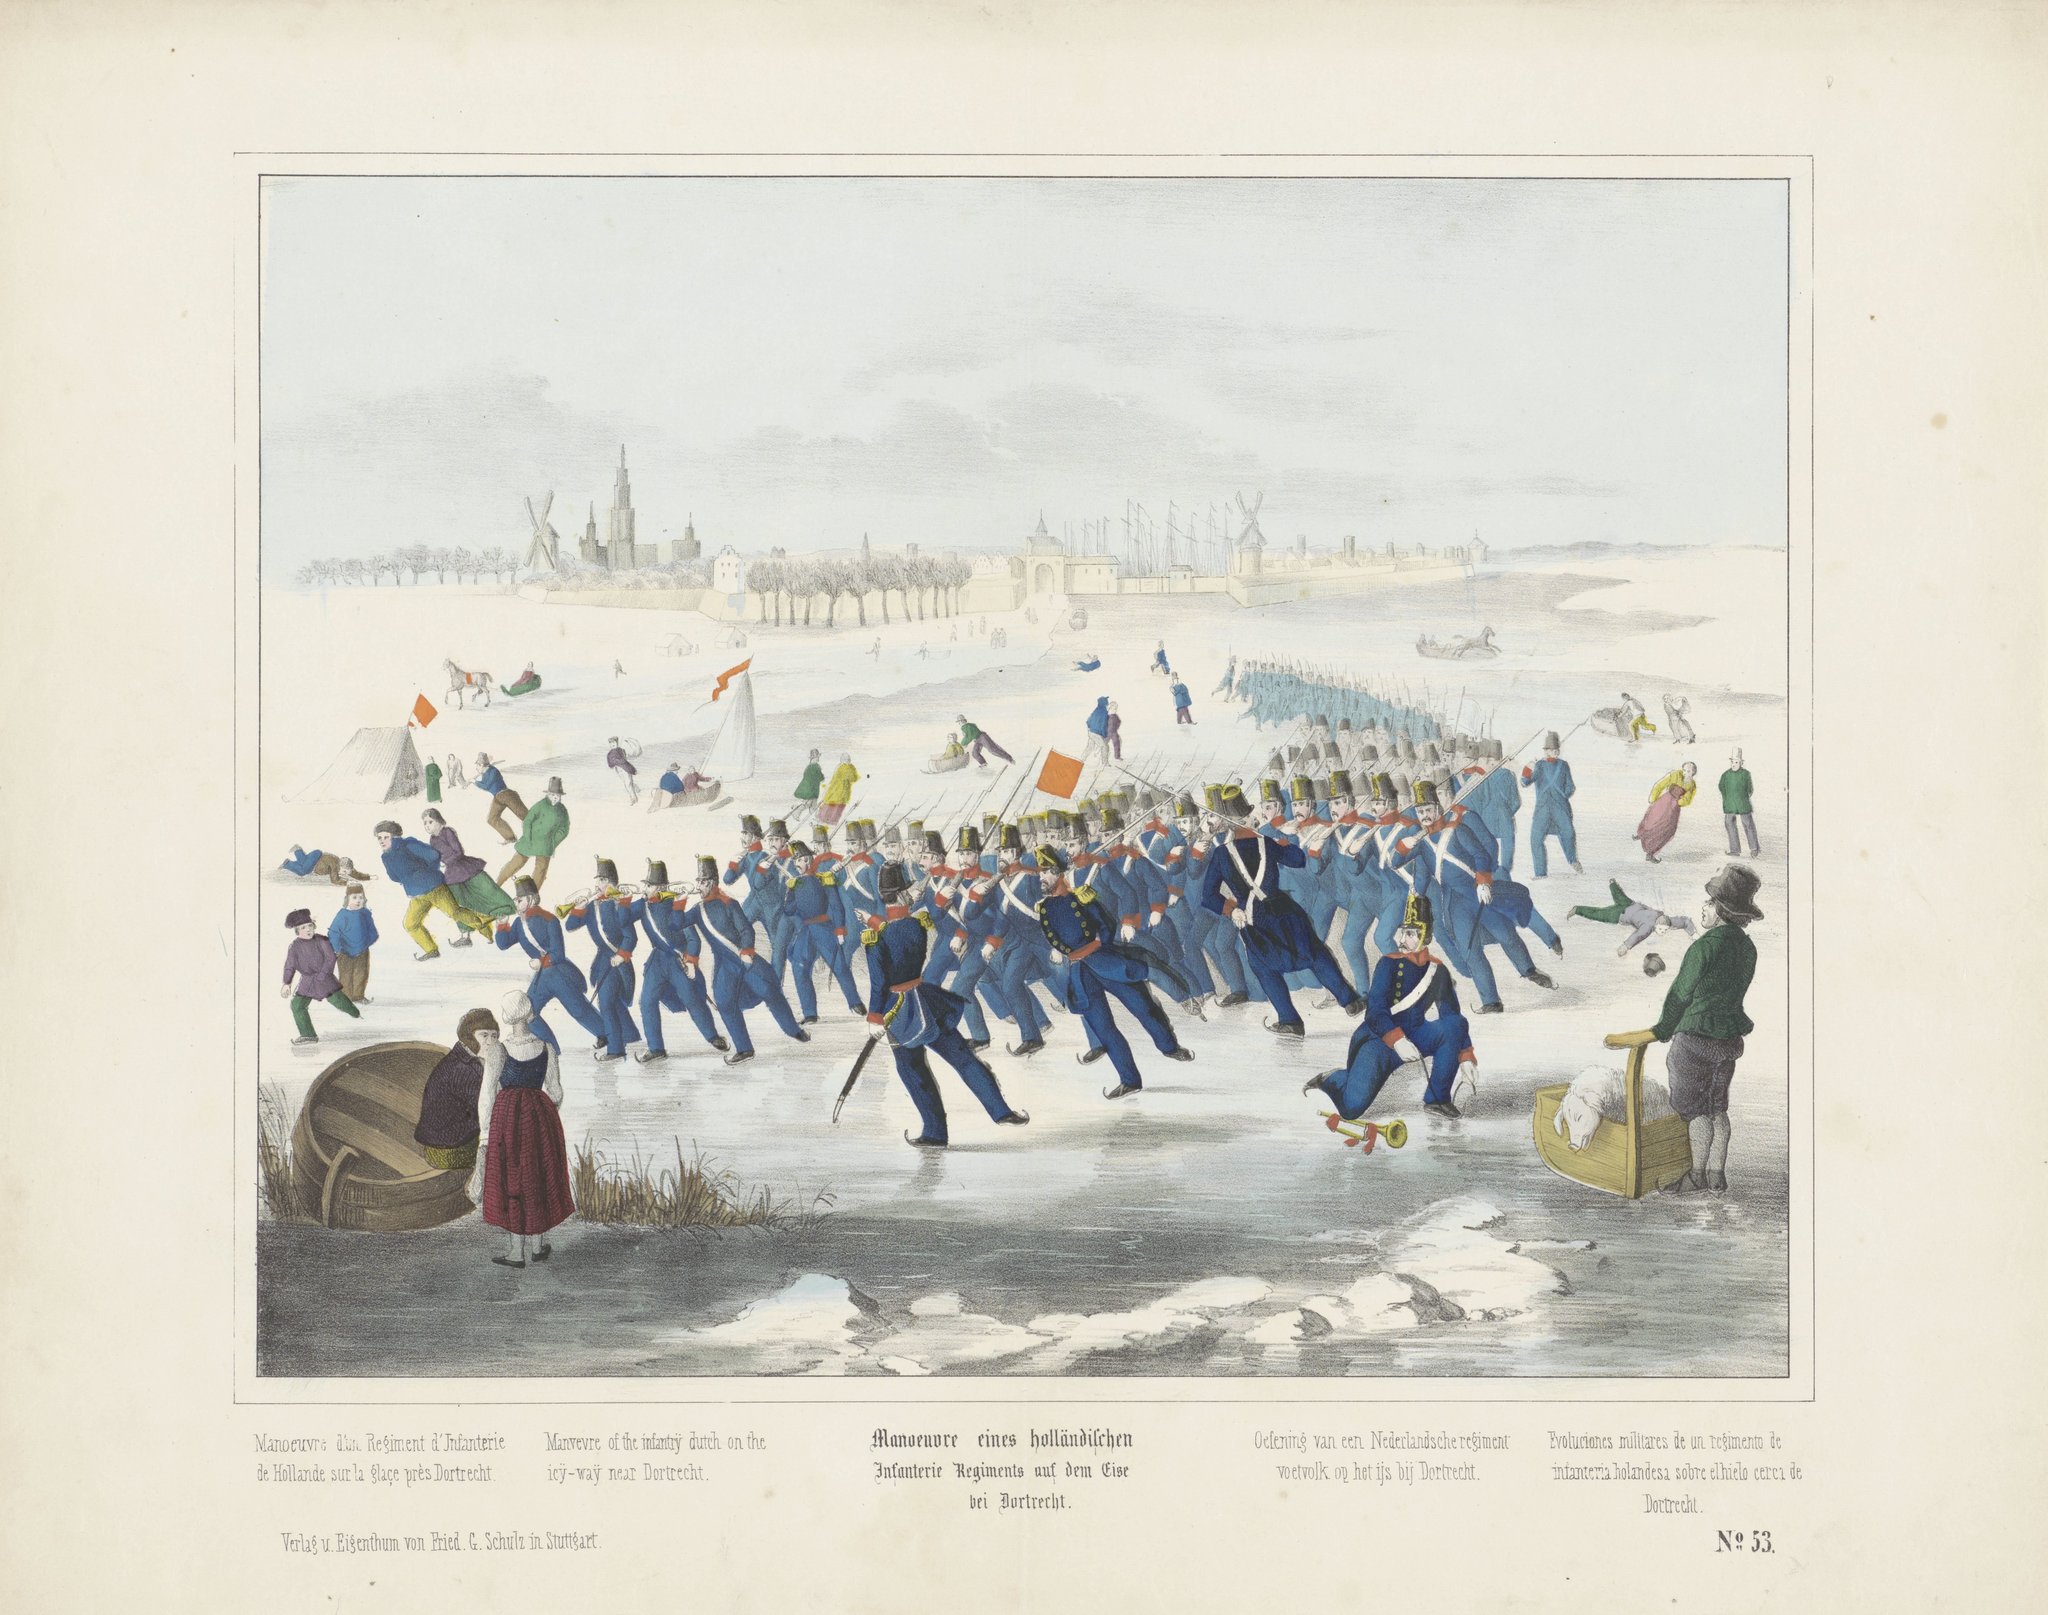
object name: print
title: Oefening van een Nederlands regiment op het ijs bij Dordrecht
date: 1820-1865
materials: paper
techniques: colour, lithograph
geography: europe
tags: skates (winter sports), the soldier; the soldier's life, dordrecht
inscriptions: collector's mark: Lugt 2760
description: Een regiment Nederlandse voetsoldaten schaatsend op het ijs. Rondom de soldaten mensen spelend op het ijs. Op de achtergond de stad Dordrecht. Onder de voorsteling de titel in vijf talen. Genummerd rechtsonder: No. 53.